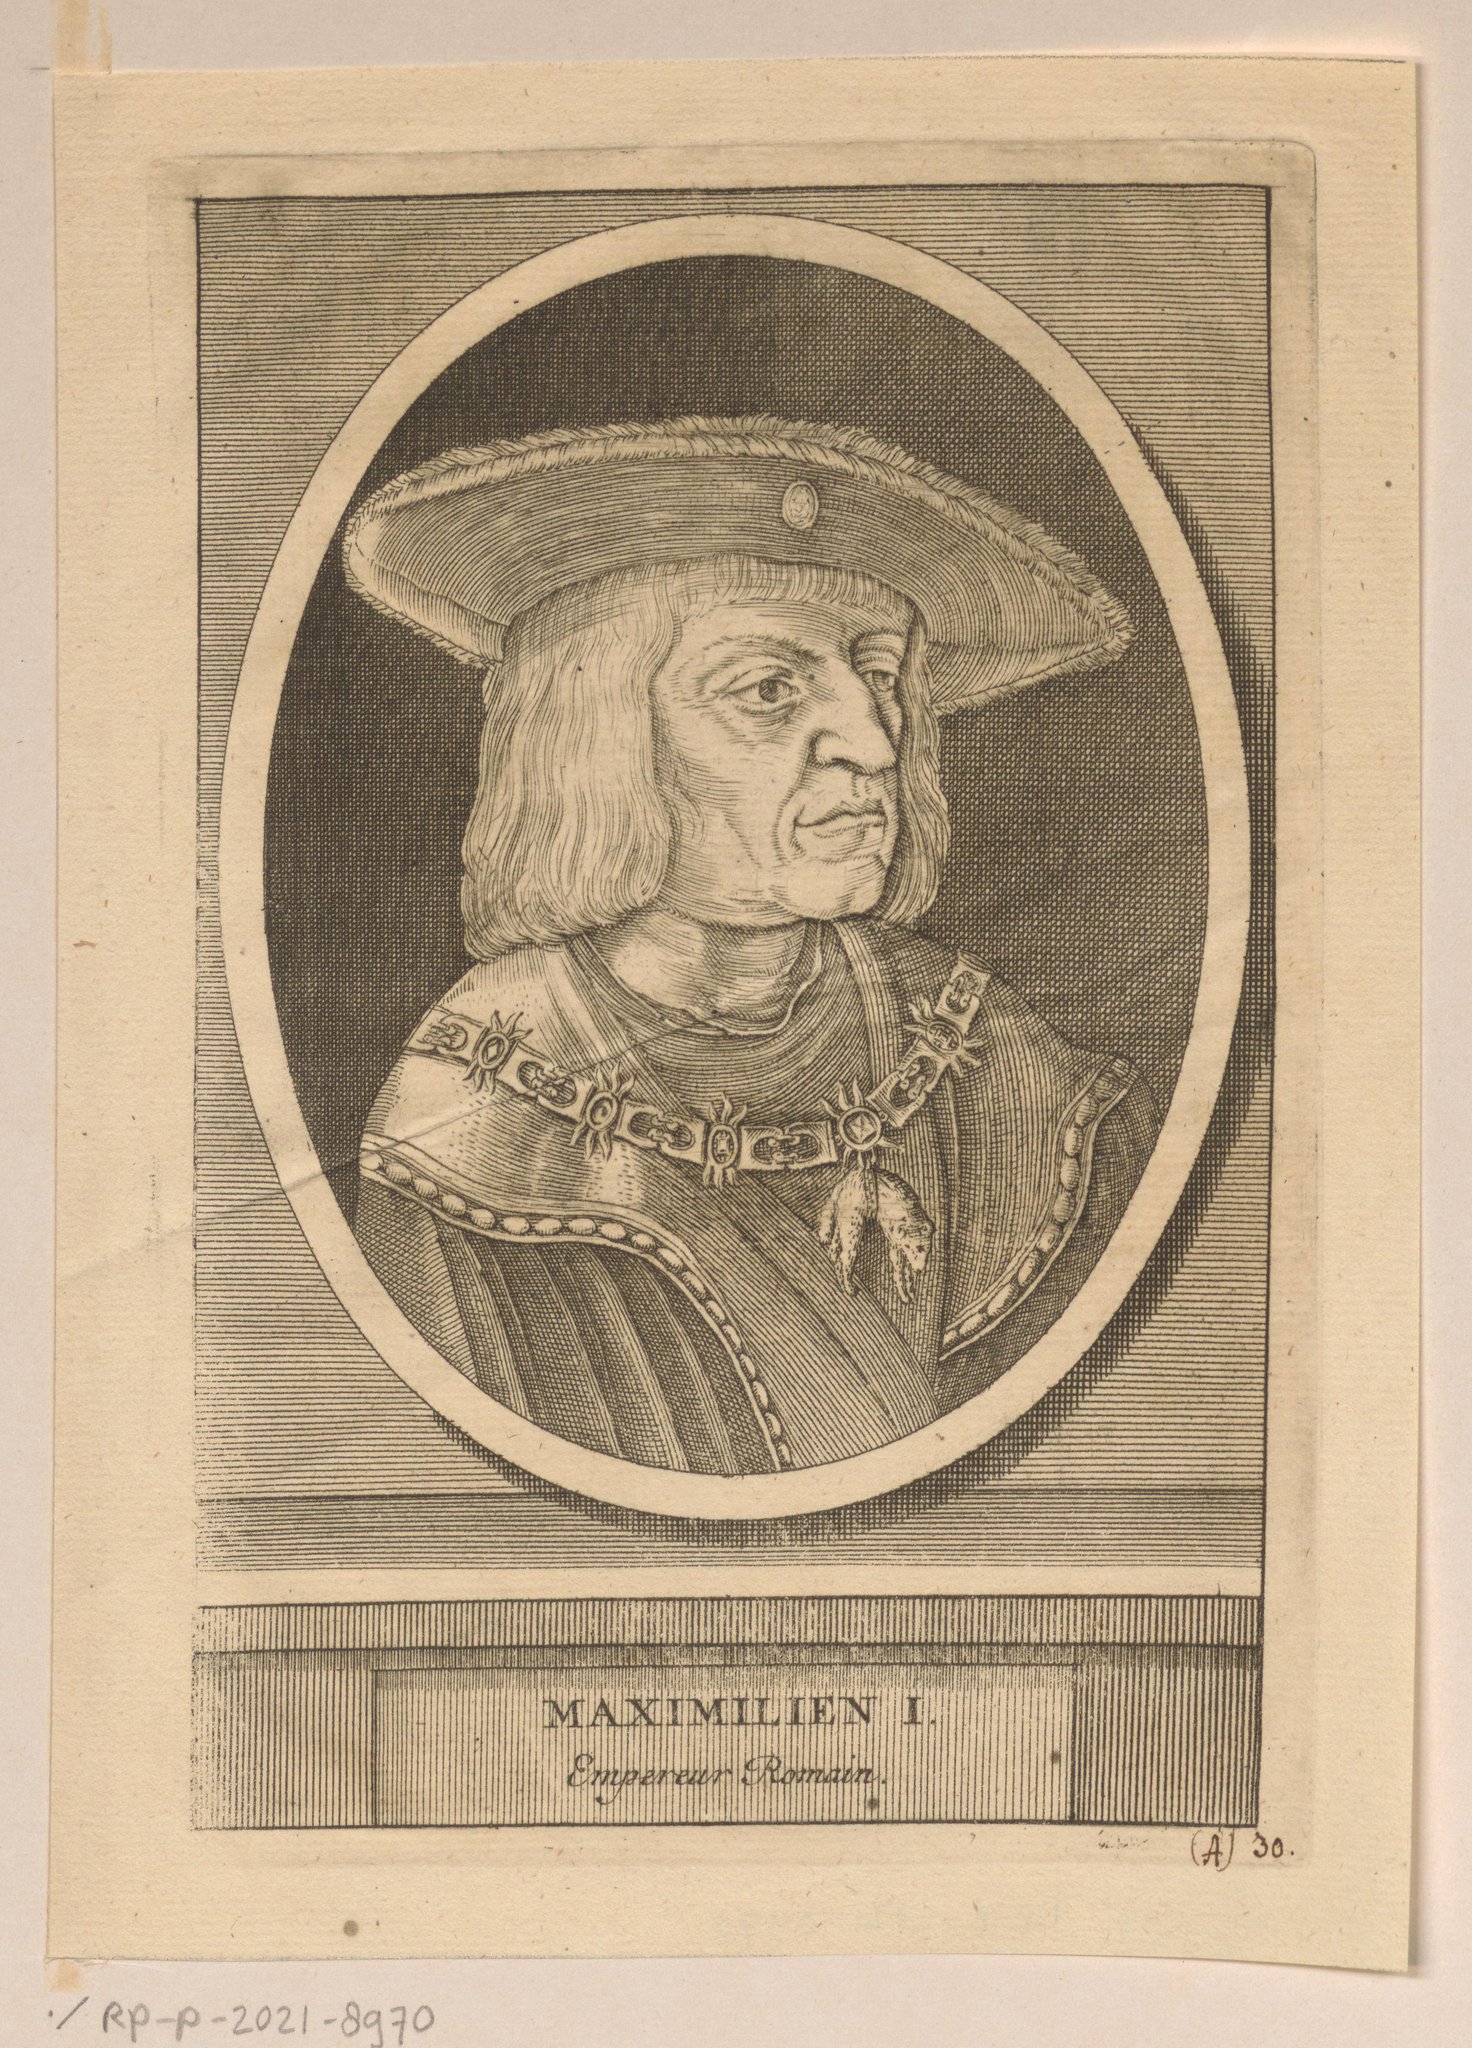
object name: print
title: Divers portraits des papes, empereurs, rois, reines, & autres personnes illustres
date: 1729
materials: paper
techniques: engraving, etching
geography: leiden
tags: maximilian i (holy roman emperor), ornament ~ medallion, historical persons, knighthood order of the golden fleece, emperor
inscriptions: number: ‘(A)30’